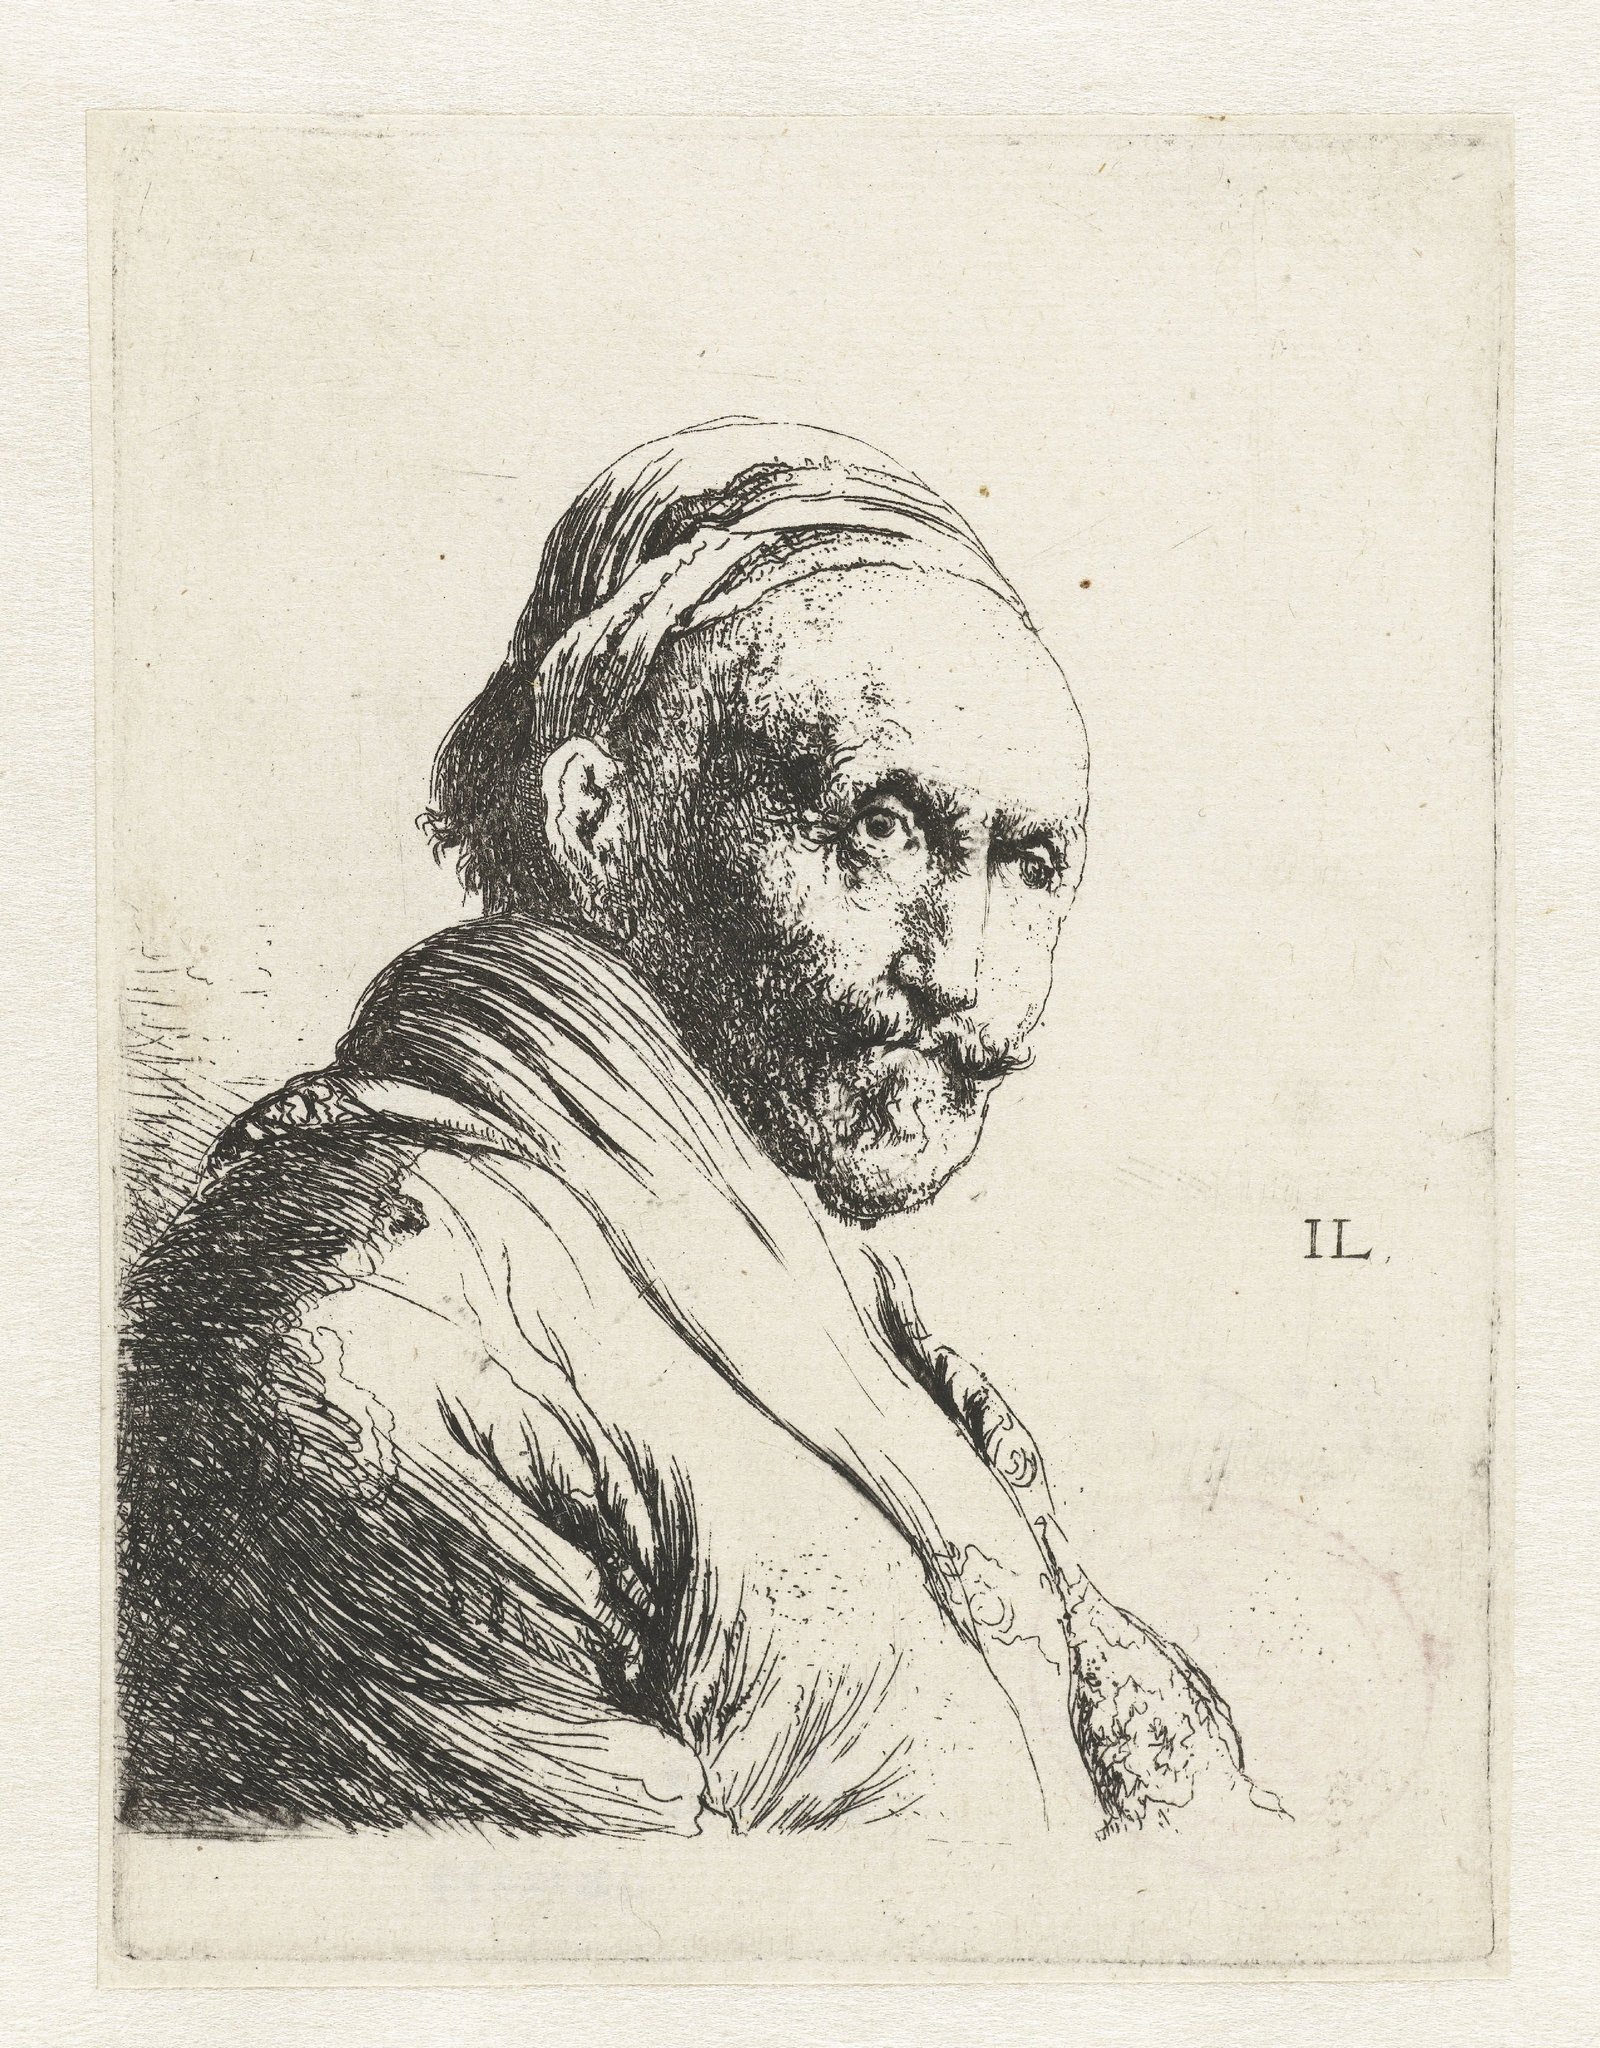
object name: print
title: Borstbeeld van een oude man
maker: jan lievens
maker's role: draughtsman, painter, print maker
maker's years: 1607-1674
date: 1625-1674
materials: paper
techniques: etching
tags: old man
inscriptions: collector's mark: Lugt 240